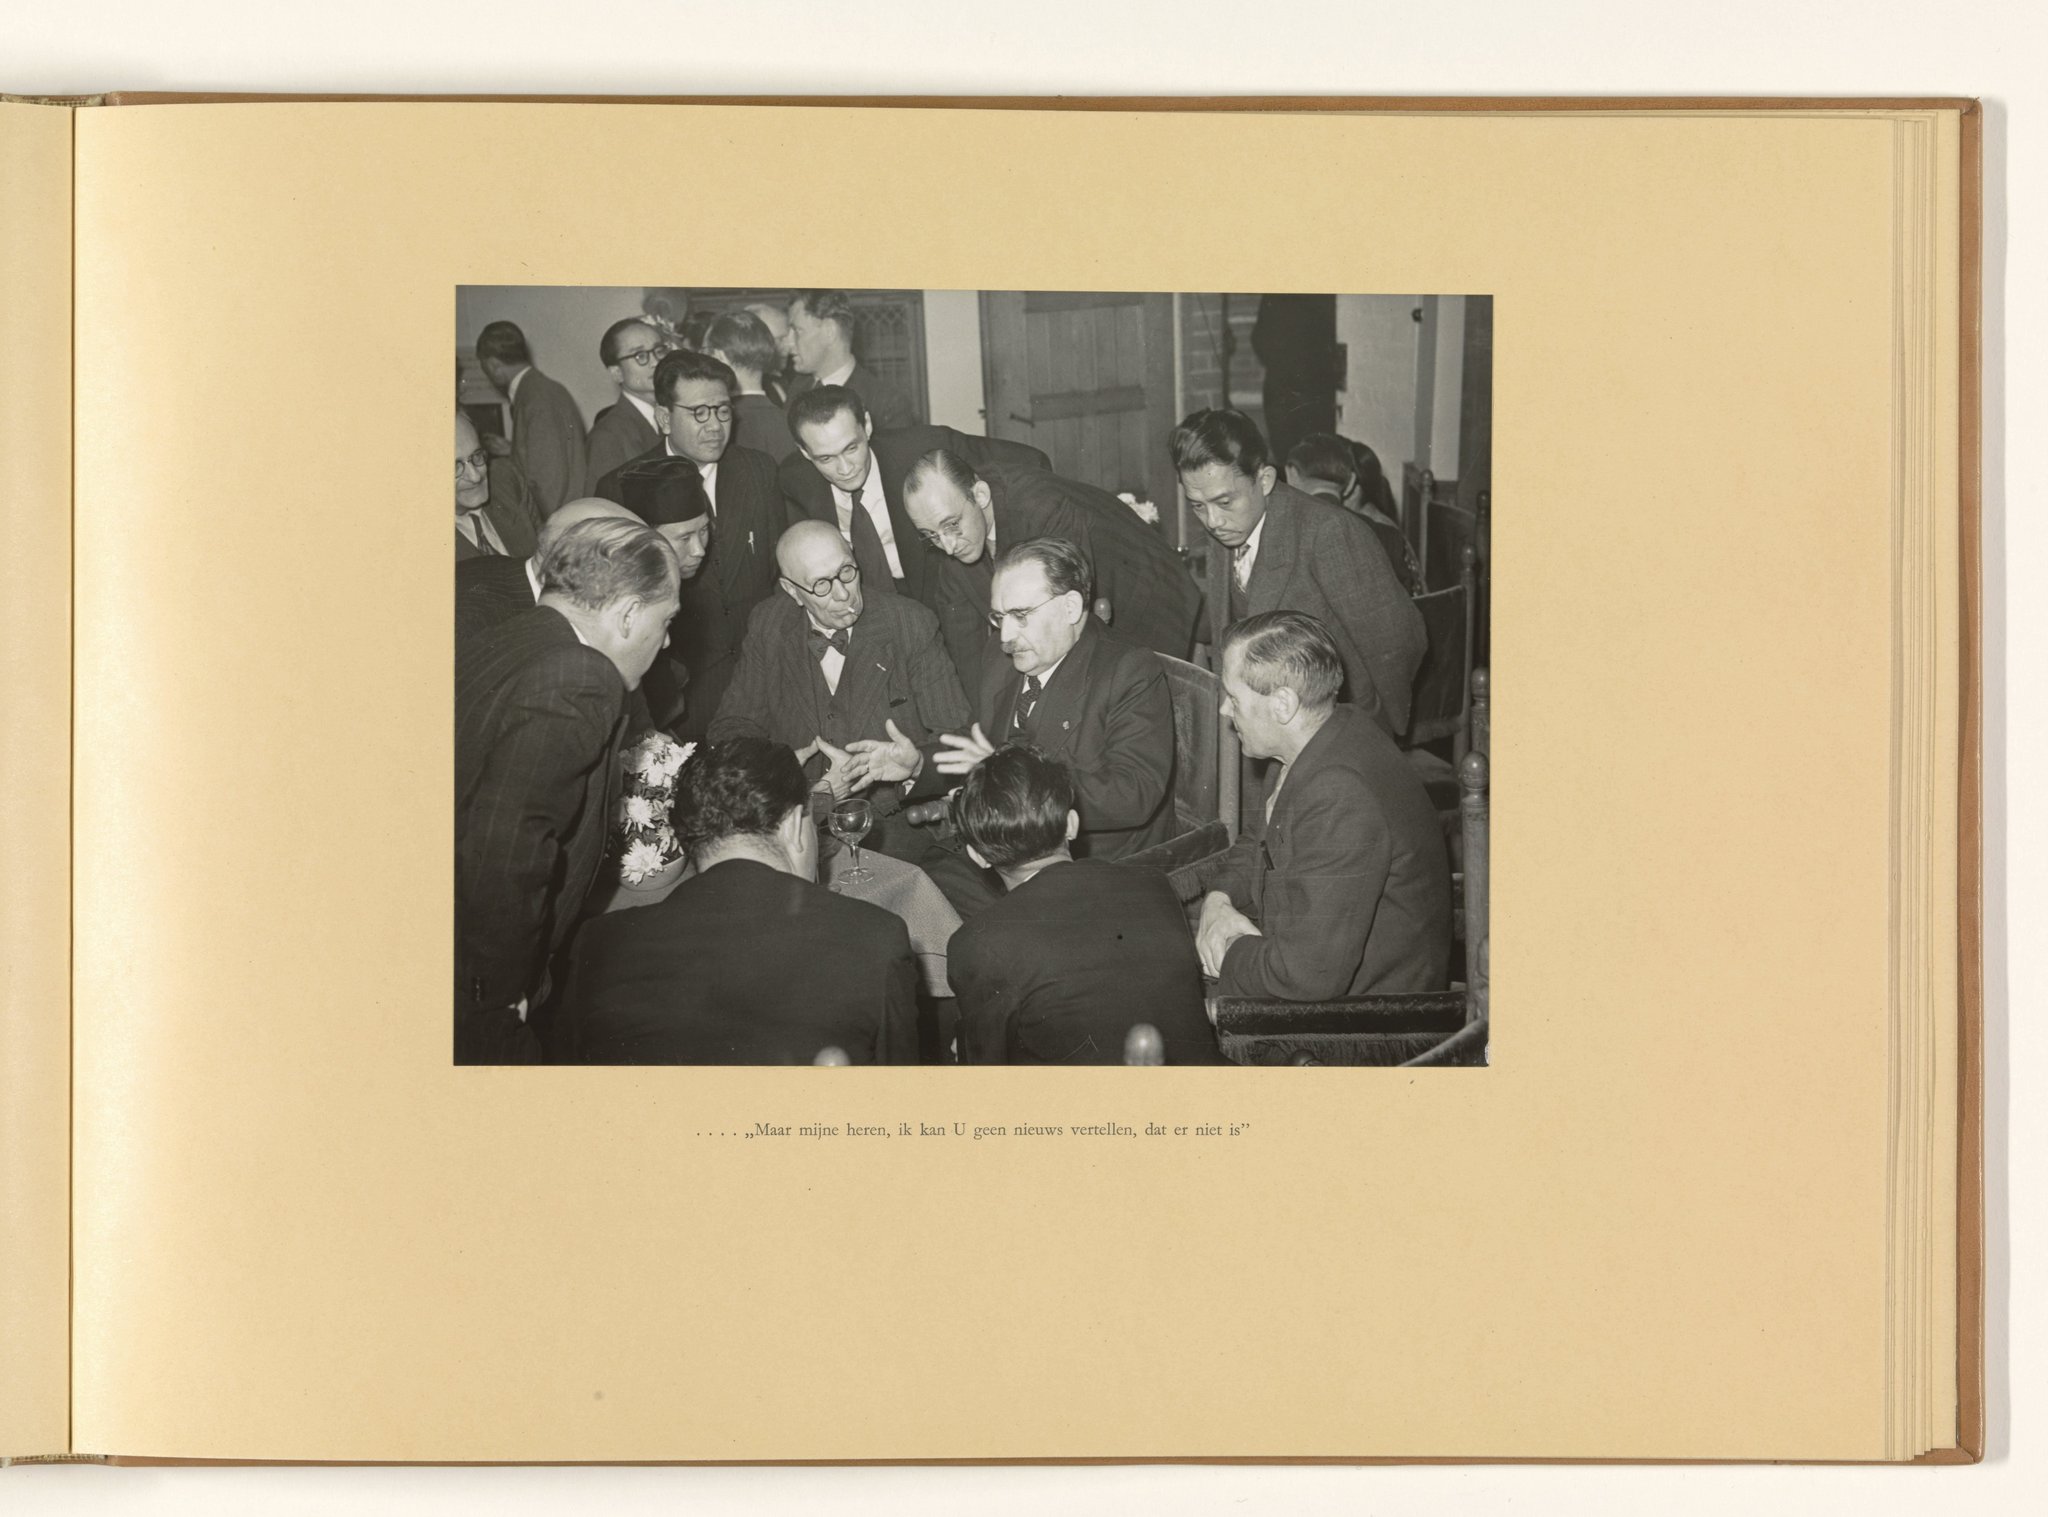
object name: photograph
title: ... "Maar mijne heren, ik kan U geen nieuws vertellen, dat er niet is"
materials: paper, photographic support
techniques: gelatin silver print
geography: the hague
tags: amsterdam, the hague, willem drees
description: Premier Drees tussen journalisten op de receptie van de Regeringsvoorlichtingsdienst. Foto in het fotoalbum met 37 foto's van de rondetafelconferentie gehouden tussen 23 augustus en 2 november in Den Haag in 1949 tussen vertegenwoordigers van Nederland, de Republiek Indonesië en de Bijeenkomst Federaal Overleg. Het exemplaar aangeboden aan premier Willem Drees.